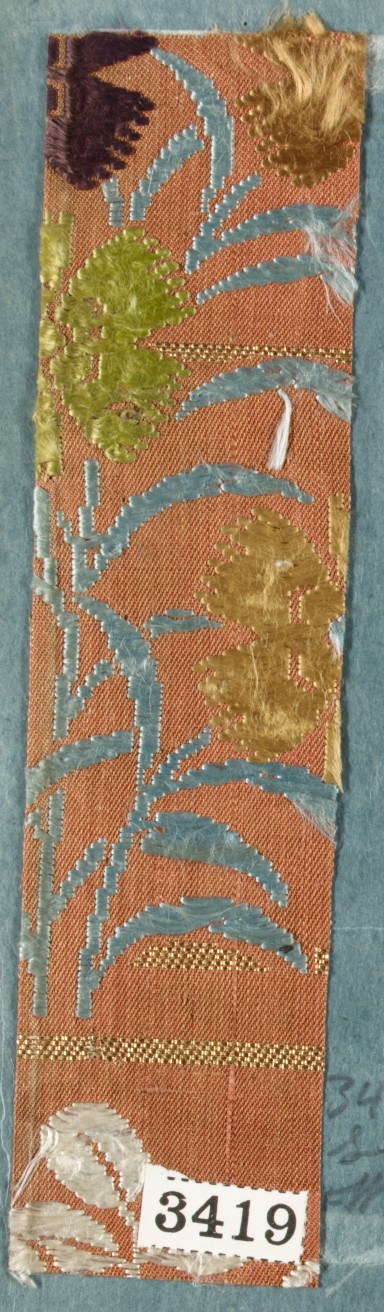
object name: textile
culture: japanese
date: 1801-1900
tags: flowers